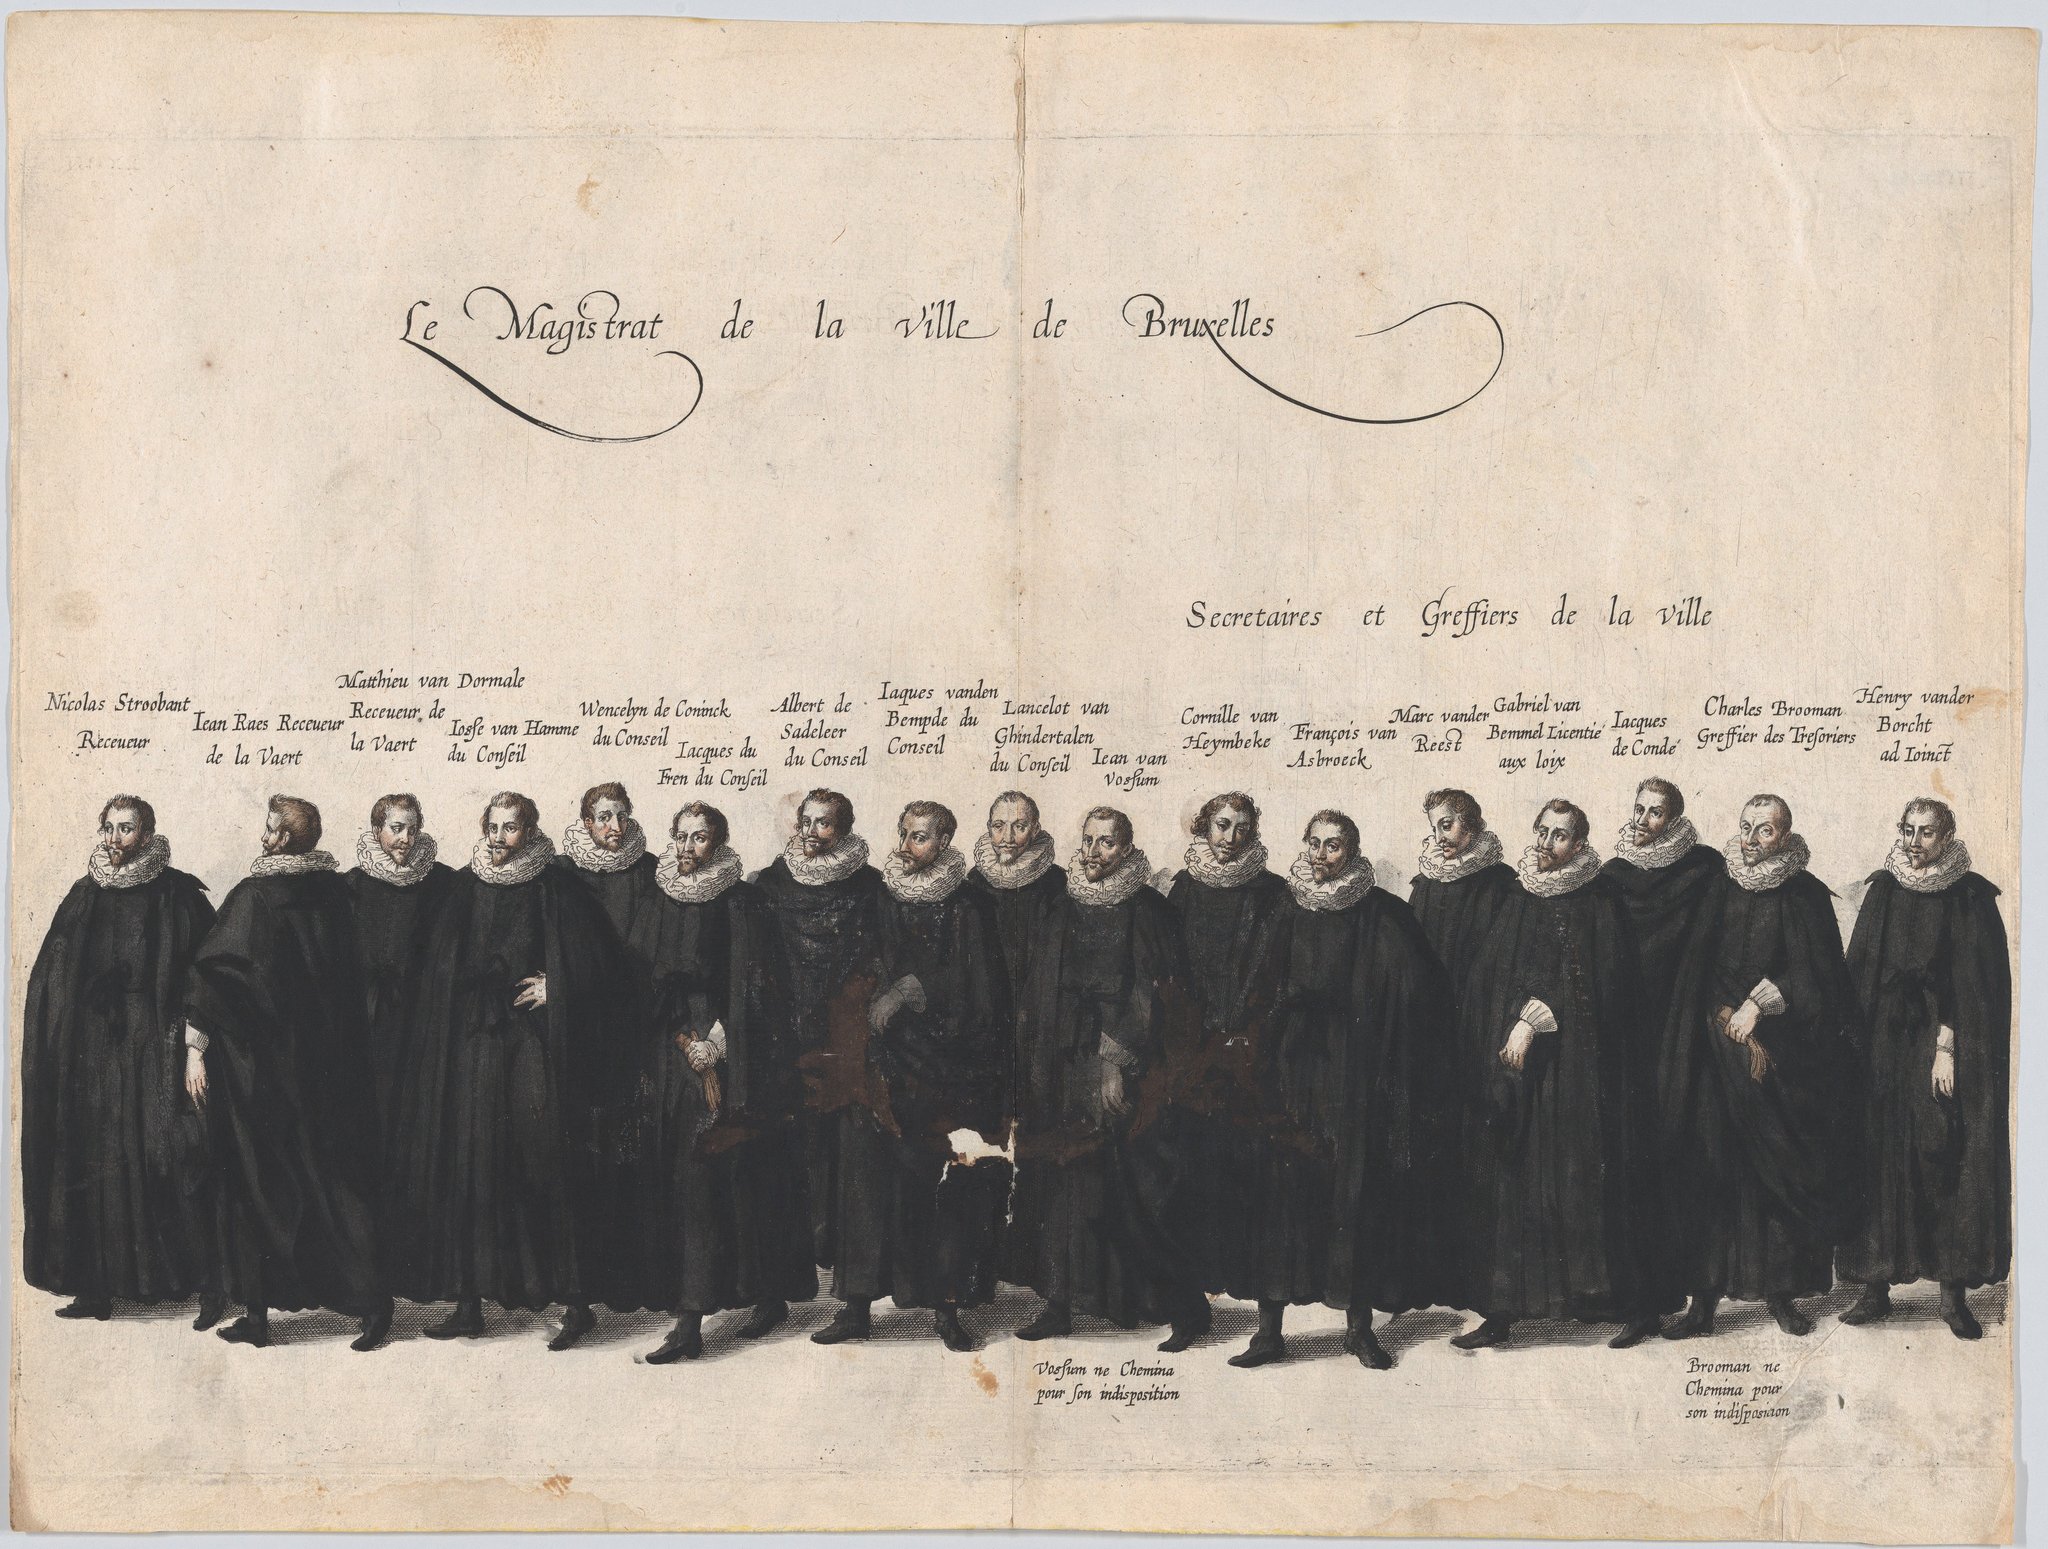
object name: print, fete, ornament architecture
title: Plate 64: The magistrates of the city of Brussels marching in the funeral procession of Archduke Albert of Austria; from 'Pompa Funebris ... Alberti Pii'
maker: cornelis galle (i)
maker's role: artist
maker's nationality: netherlandish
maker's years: 1576-1650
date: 1623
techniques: etching, hand coloring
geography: brussels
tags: men,funerals